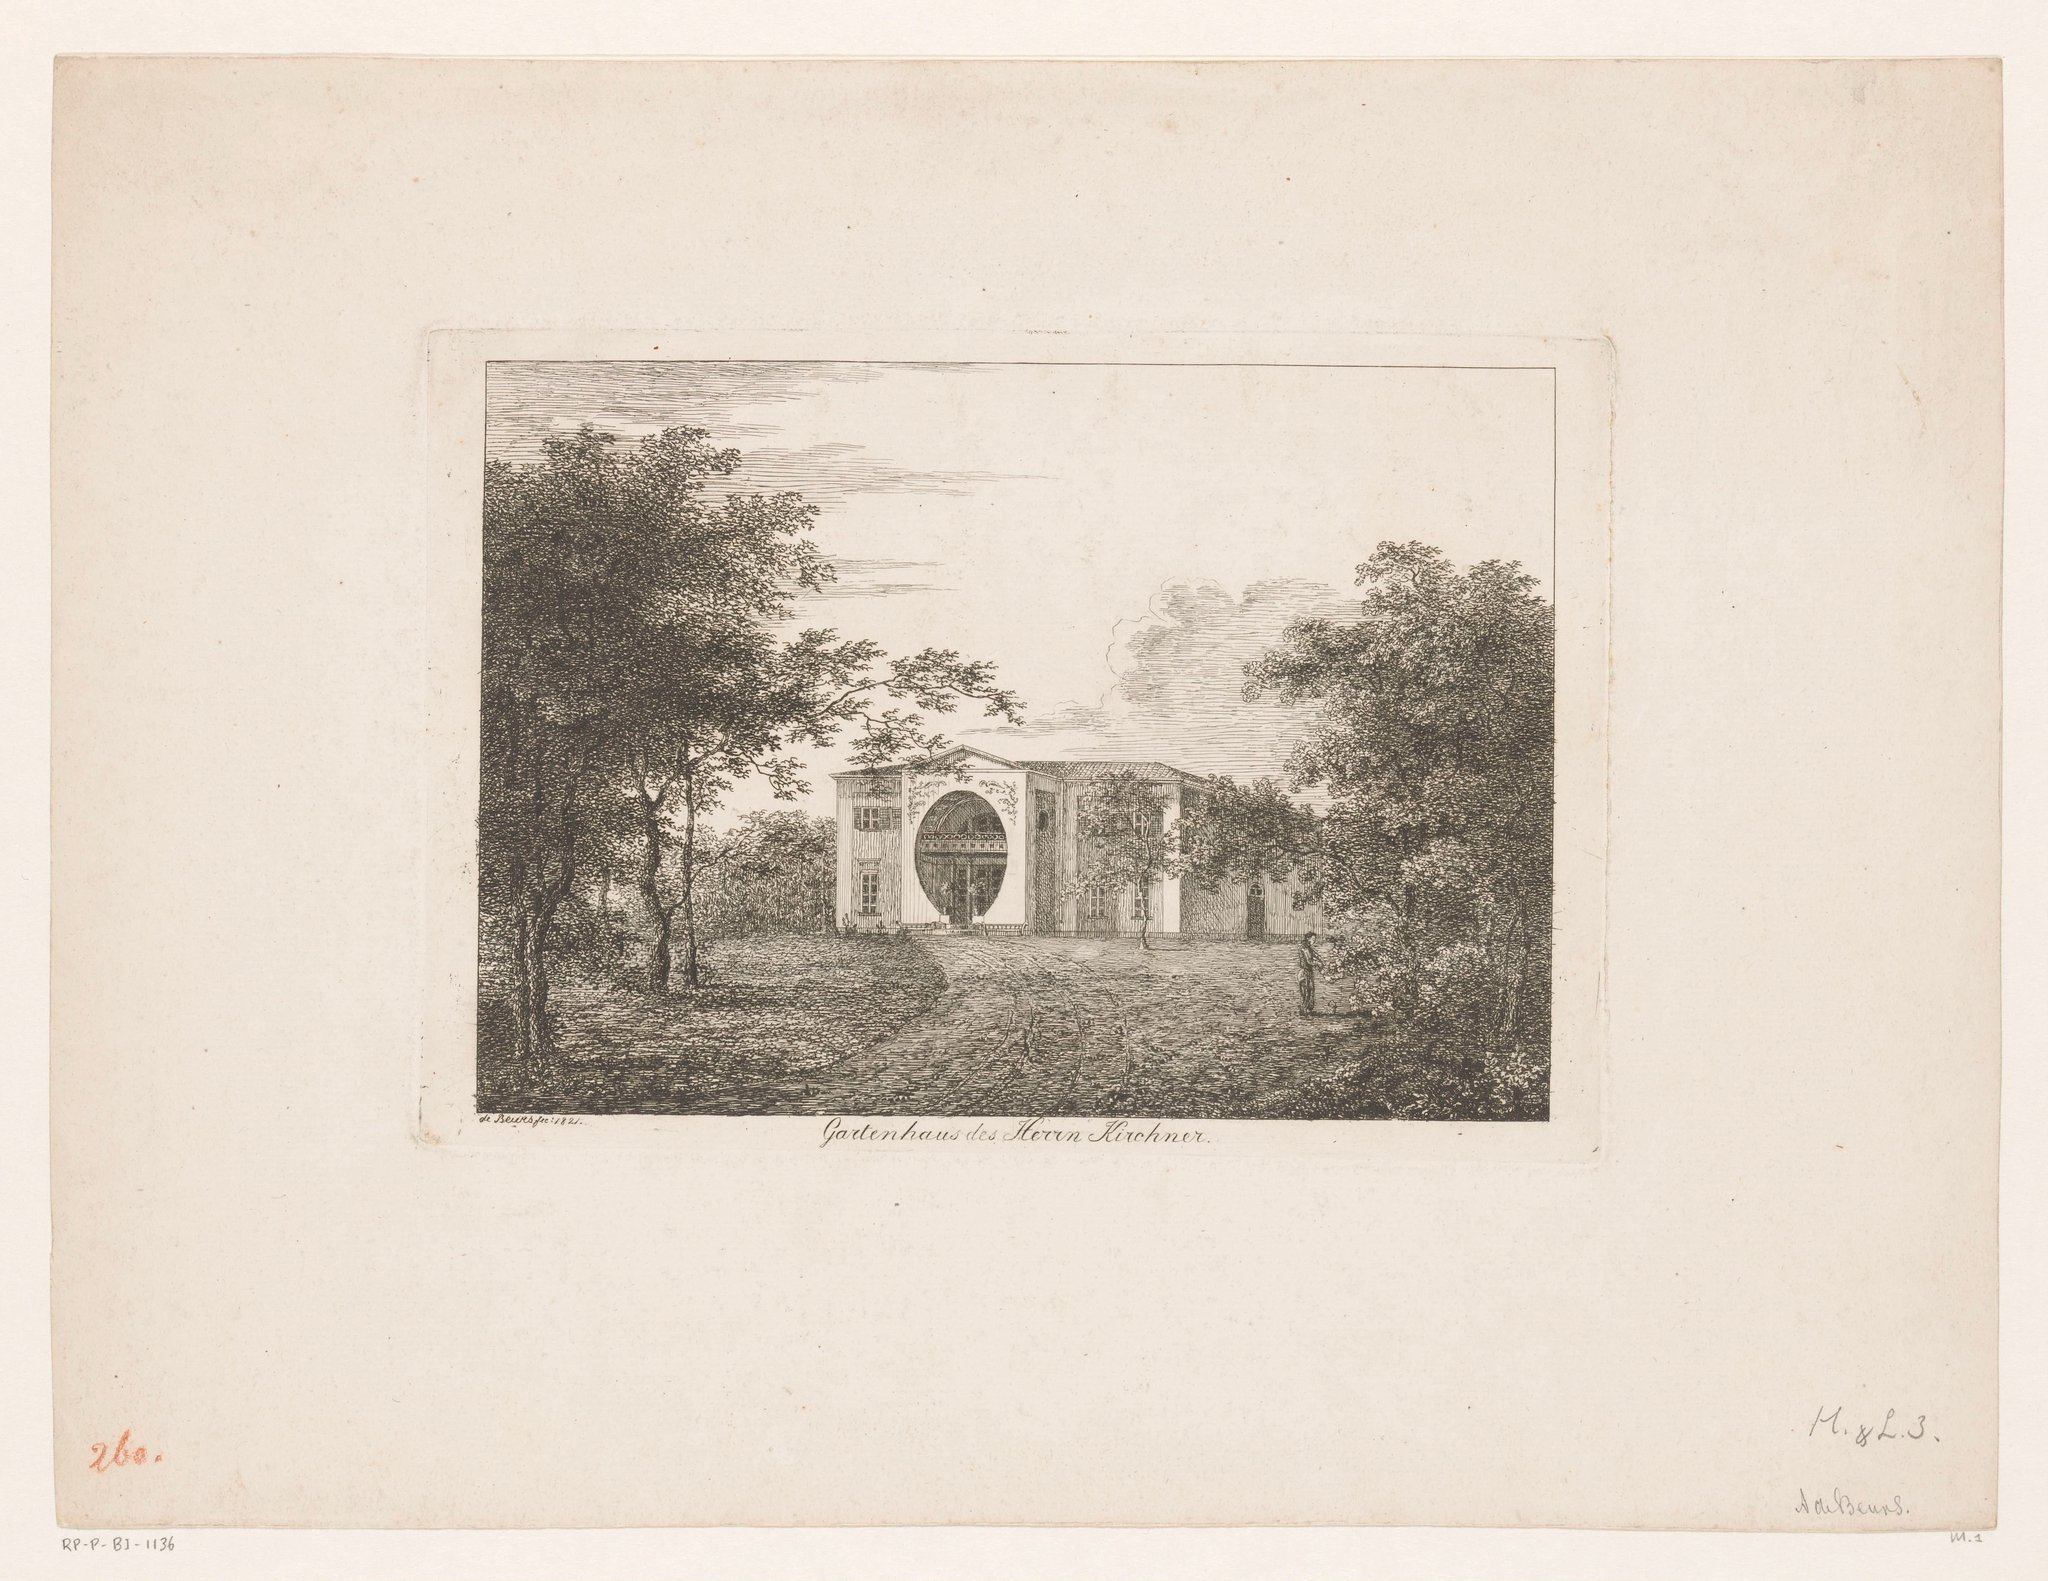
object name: print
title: Buitenhuis van Kirchner nabij Hamburg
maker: andré paul de beurs-stiermans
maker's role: print maker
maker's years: 1802-1832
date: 1821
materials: paper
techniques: etching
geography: hamburg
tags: country-house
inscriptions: collector's mark: Lugt 2228